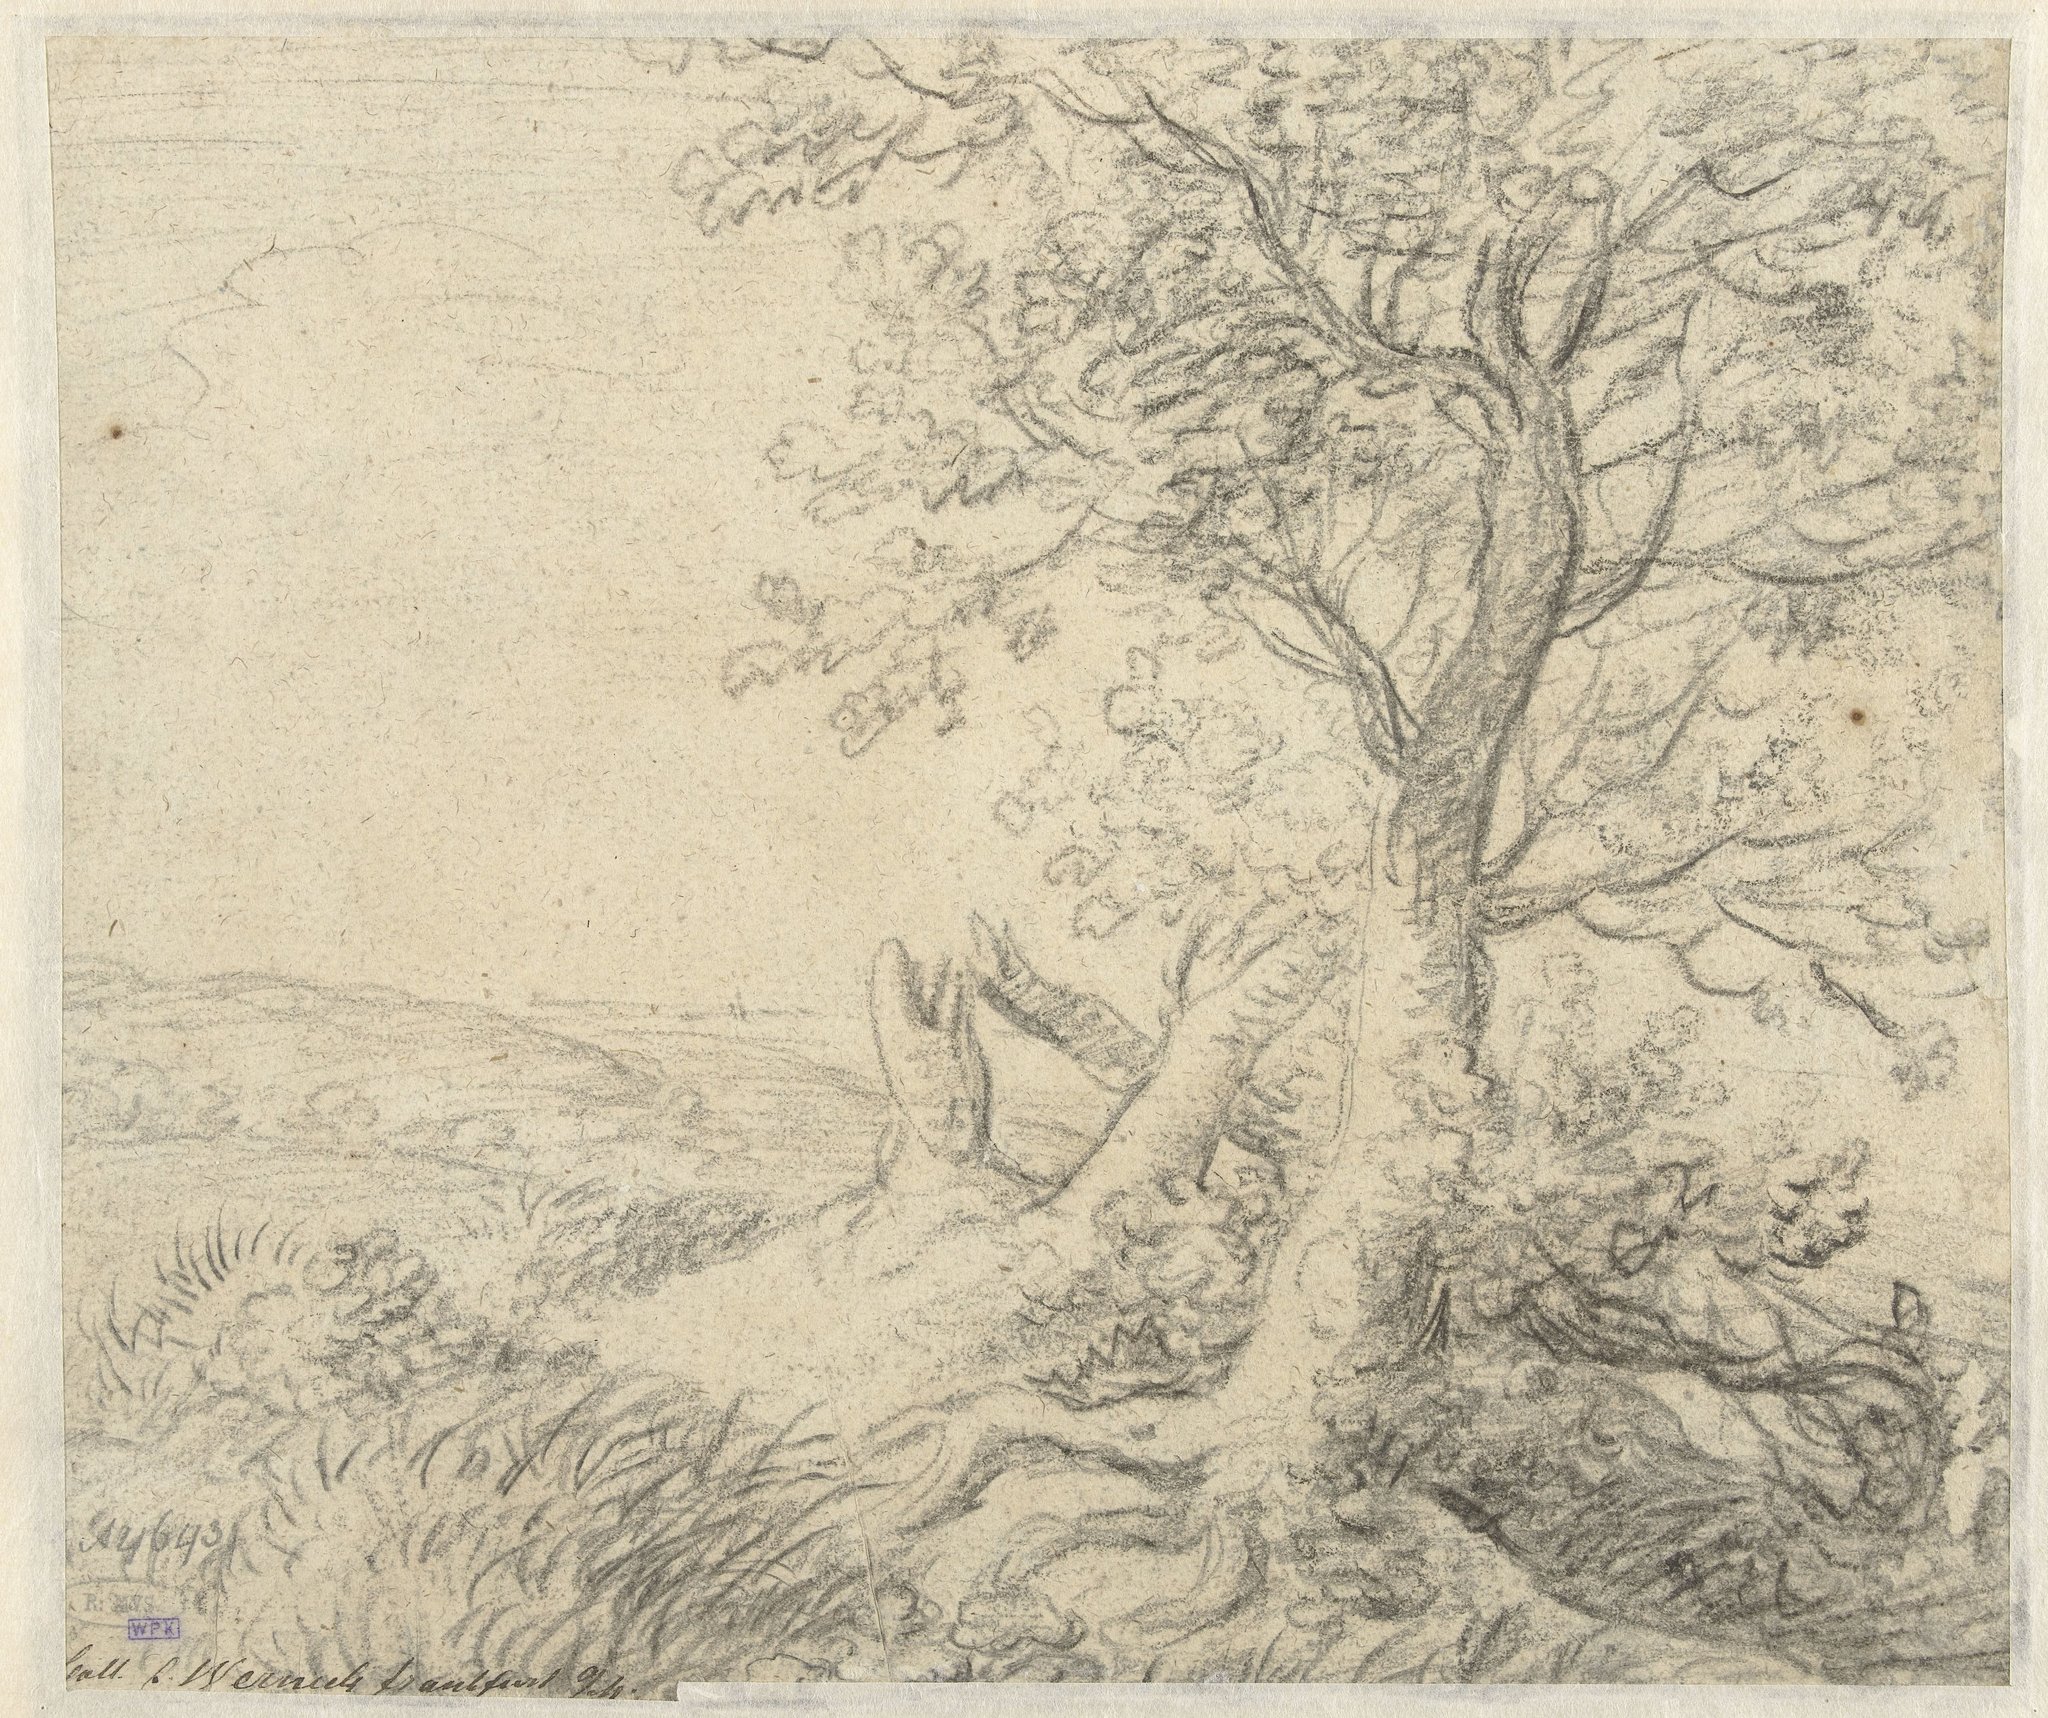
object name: drawing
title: Schets van een landschap met drie bomen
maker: anthonie waterloo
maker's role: draughtsman, painter, print maker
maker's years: 1609-1690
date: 1619-1690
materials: chalk, paper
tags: low hill country, trees